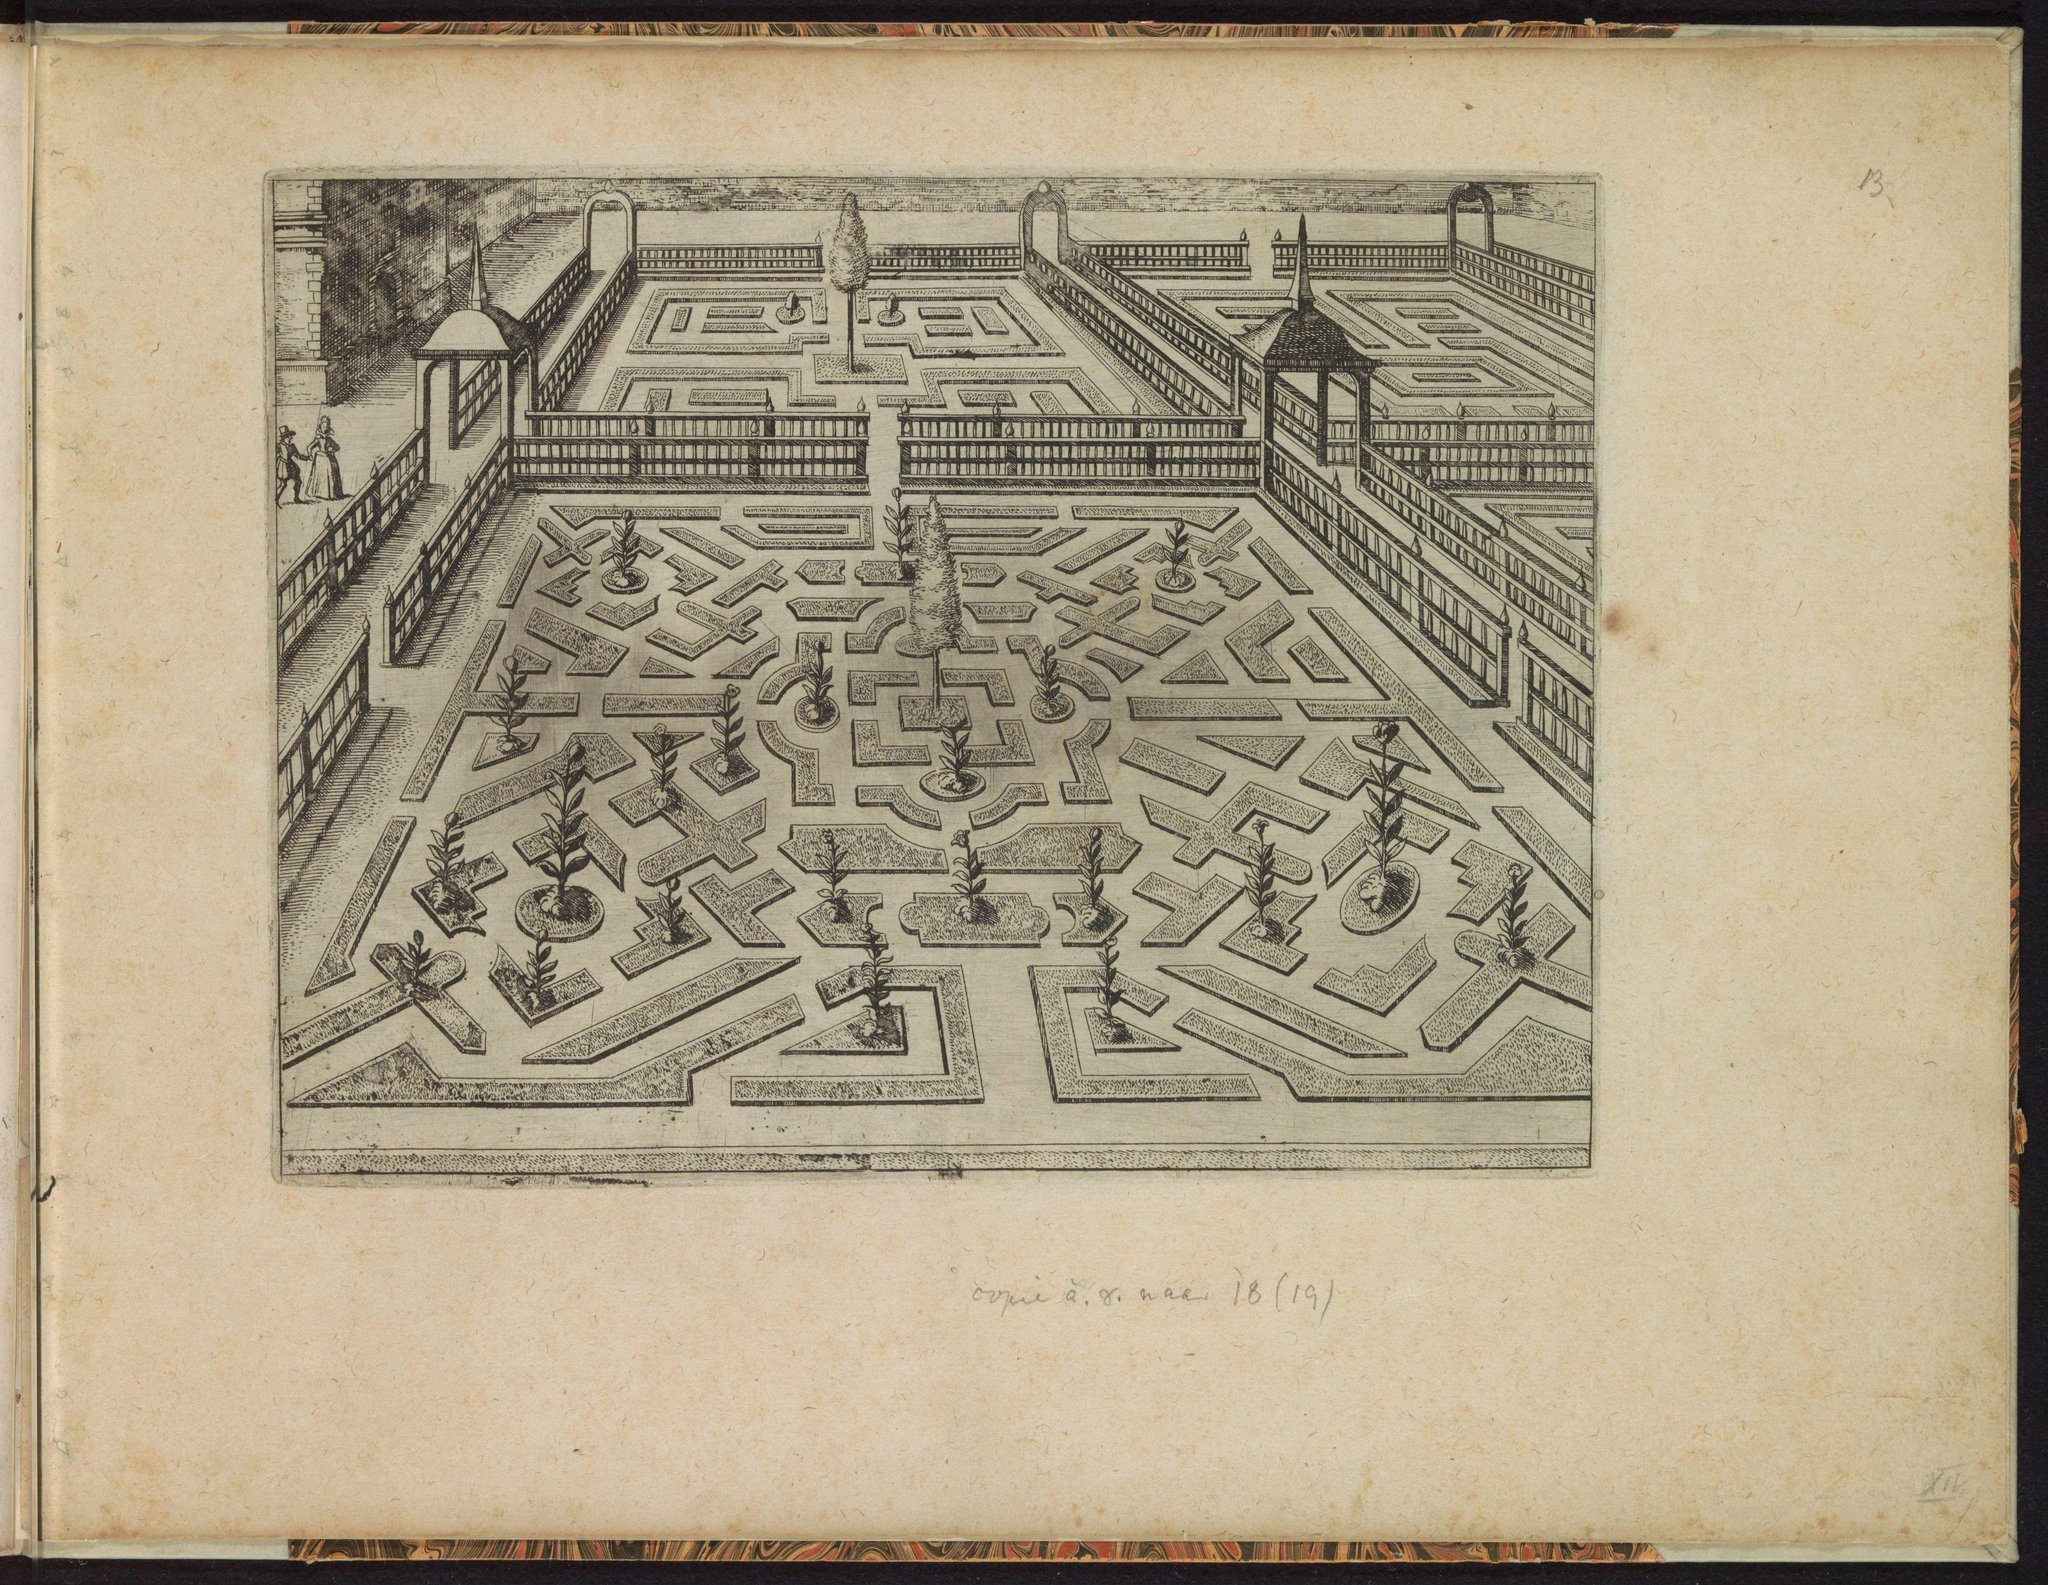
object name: print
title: Hortorum Viridariorumque elegantes et multiplicis formae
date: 1615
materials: paper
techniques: etching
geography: cologne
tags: garden, french or architectonic garden; formal garden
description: Tuin met een parterre met in de diagonalen vierkante compartimenten en in de hoeken een kruis. De tuin is aangelegd volgens de Ionische bouworde. De prent maakt deel uit van een album.